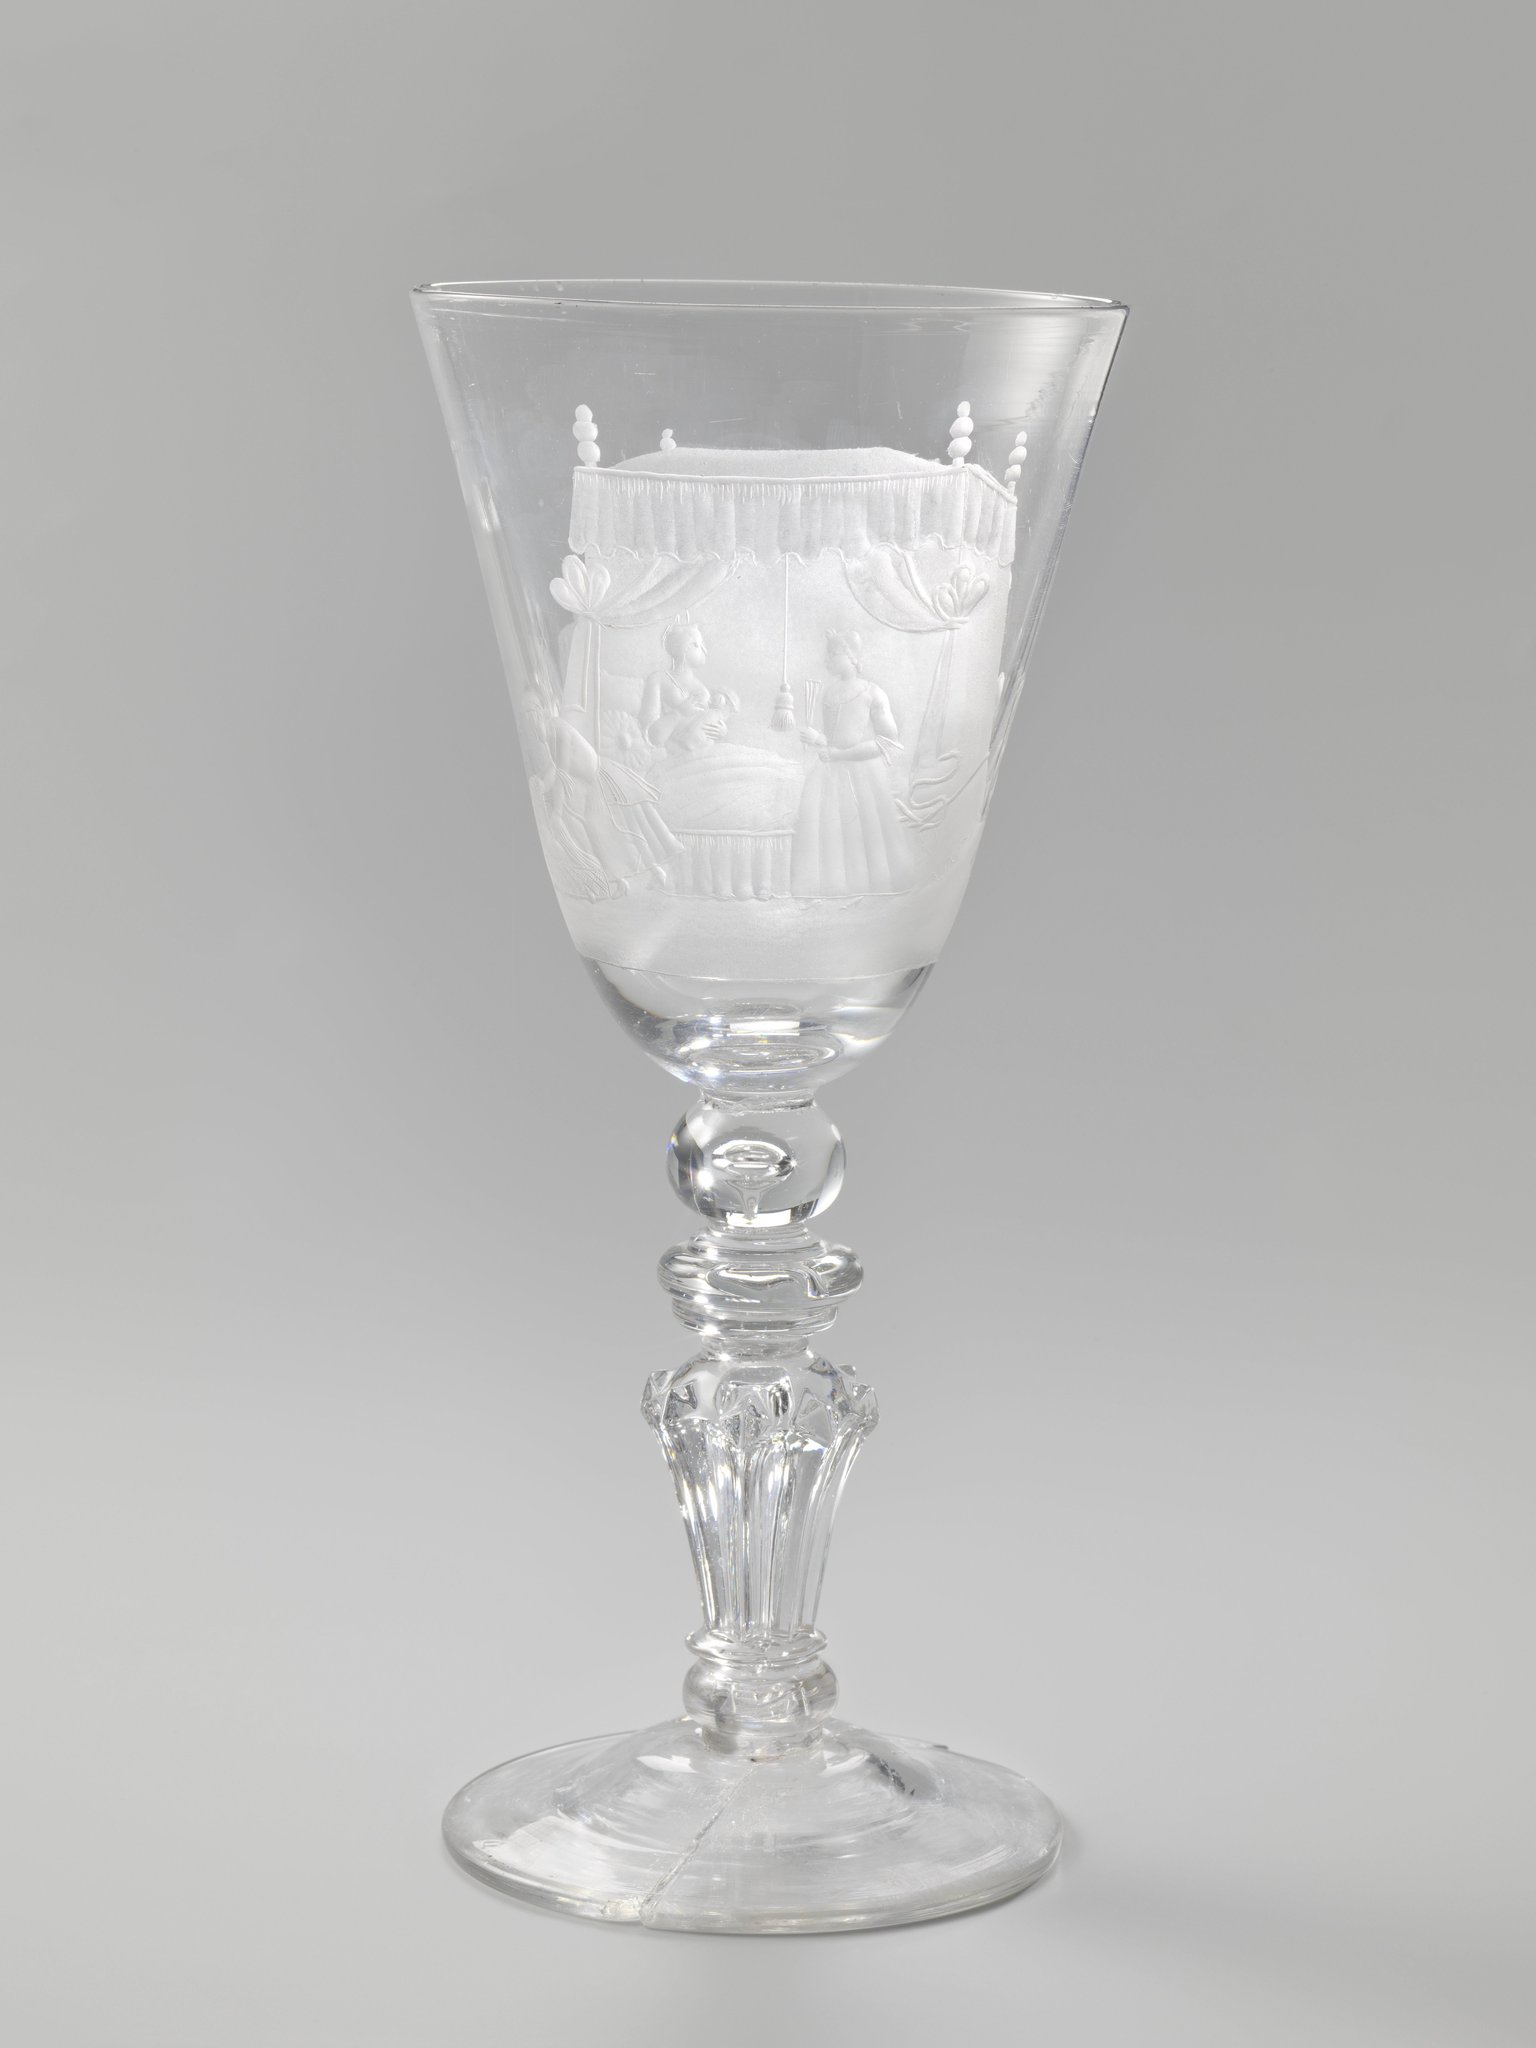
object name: goblet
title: Wine glass with a scene of a lying-in chamber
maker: Anonymous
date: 1725-1750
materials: glass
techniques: glassblowing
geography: northern netherlands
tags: visiting the new mother, lying-in visit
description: Gewelfde voet. Achthoekige in vorm geblazen stam met knopen en een luchtbel. Conische kelk met afgeronde bodem. Op de kelk moeder met kind in het kraambed en de kraamheer kandeel trakterende aan een groot gezelschap. De voet is gebroken.